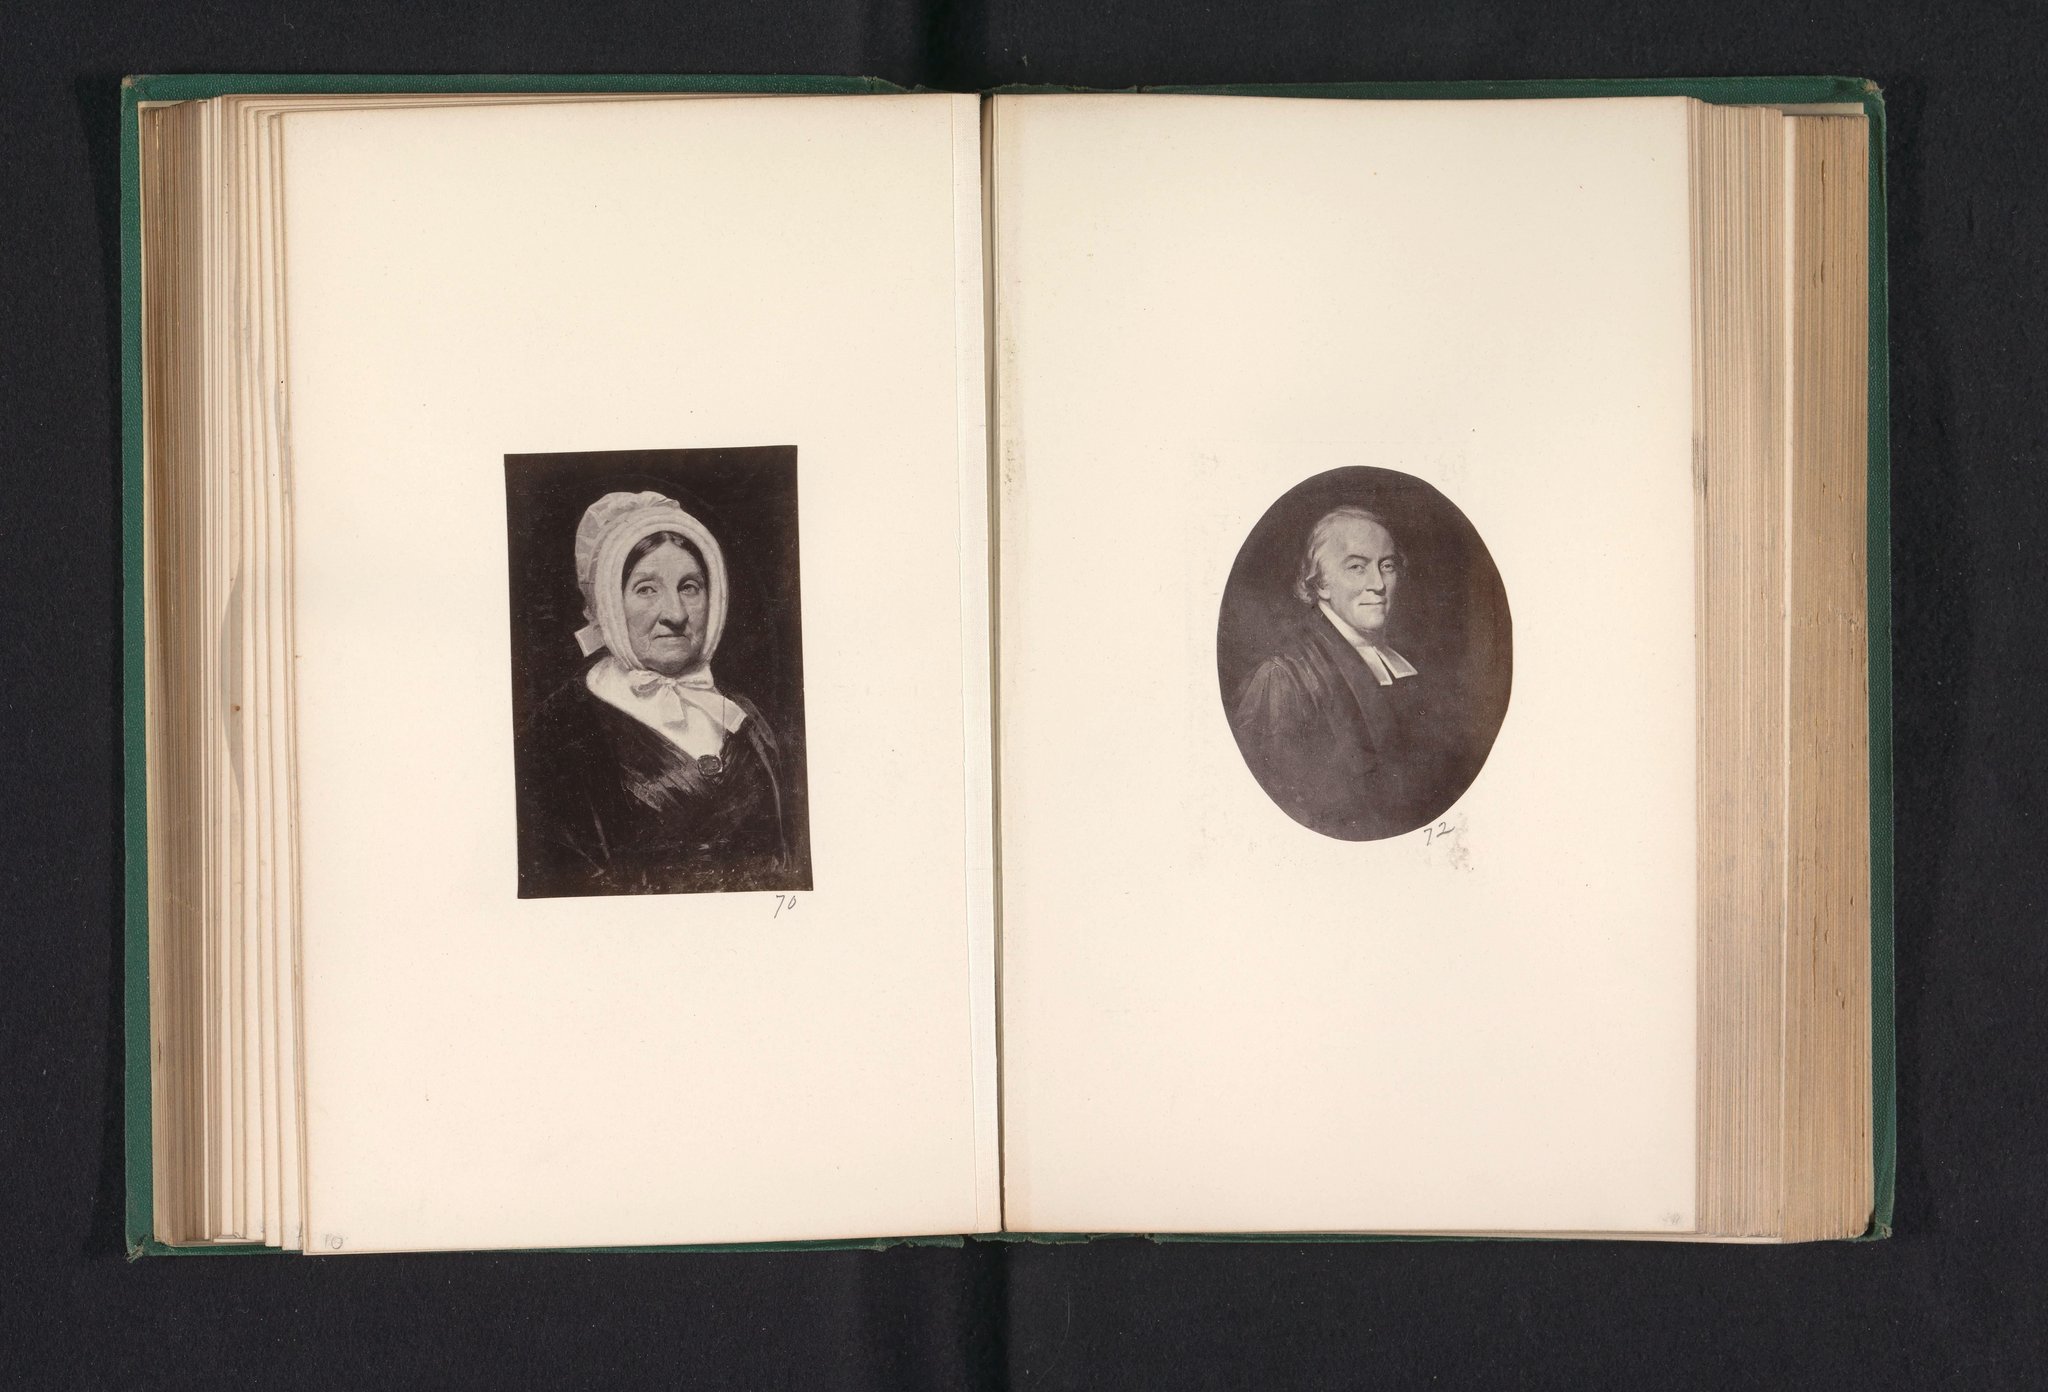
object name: photograph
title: Fotoreproductie van een schilderij, voorstellende een portret van John Henderson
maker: thomas annan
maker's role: fotograaf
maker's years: 1829-1887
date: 1863-1868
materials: photographic support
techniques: albumen print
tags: historical persons (portraits and scenes from the life) (+ (full) bust portrait)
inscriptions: number: ‘72’